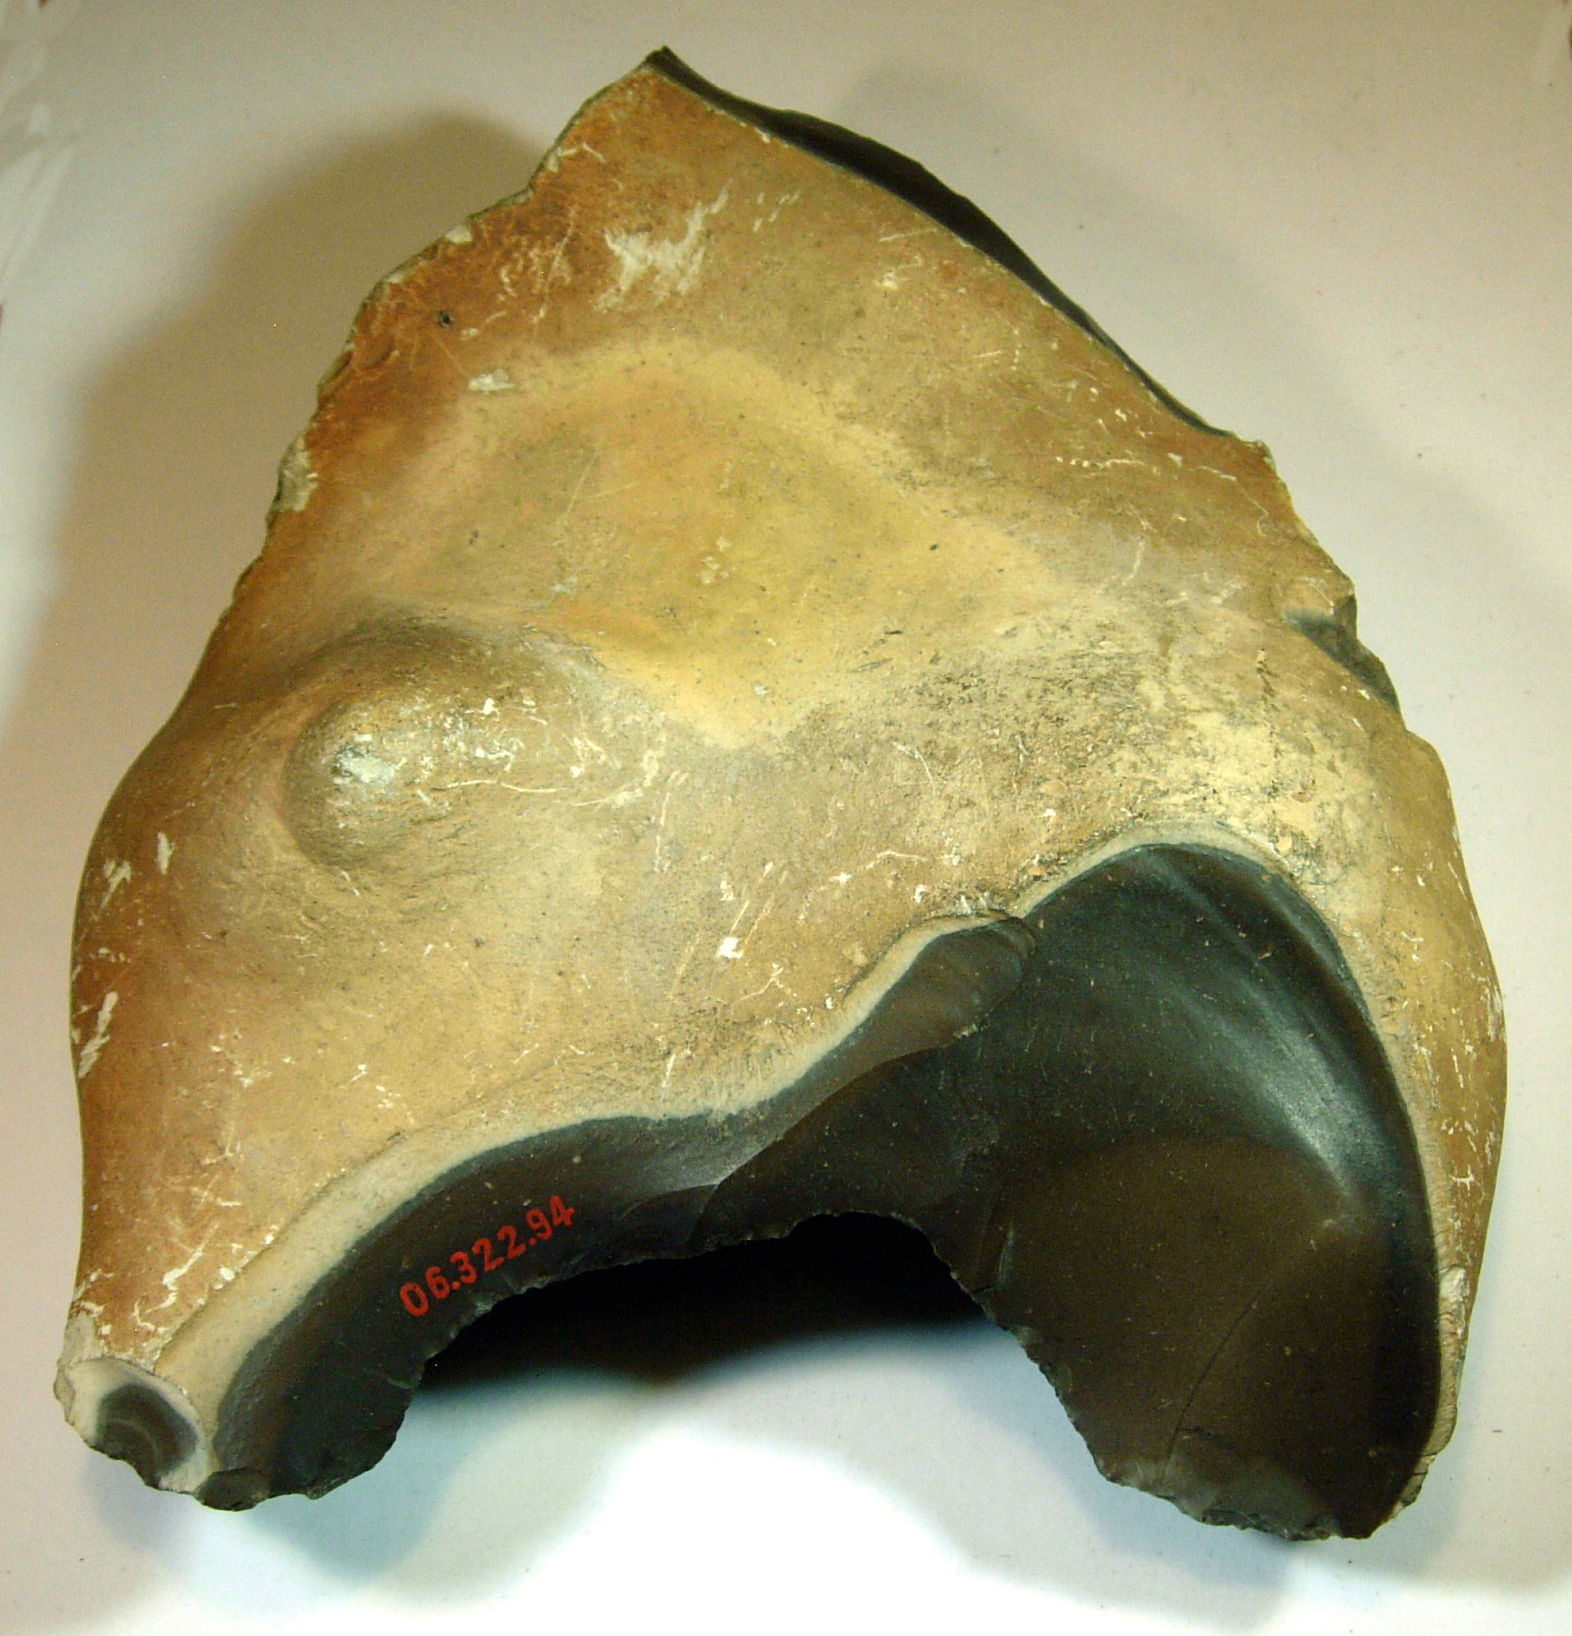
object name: tool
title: Tool (?)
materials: stone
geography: egypt